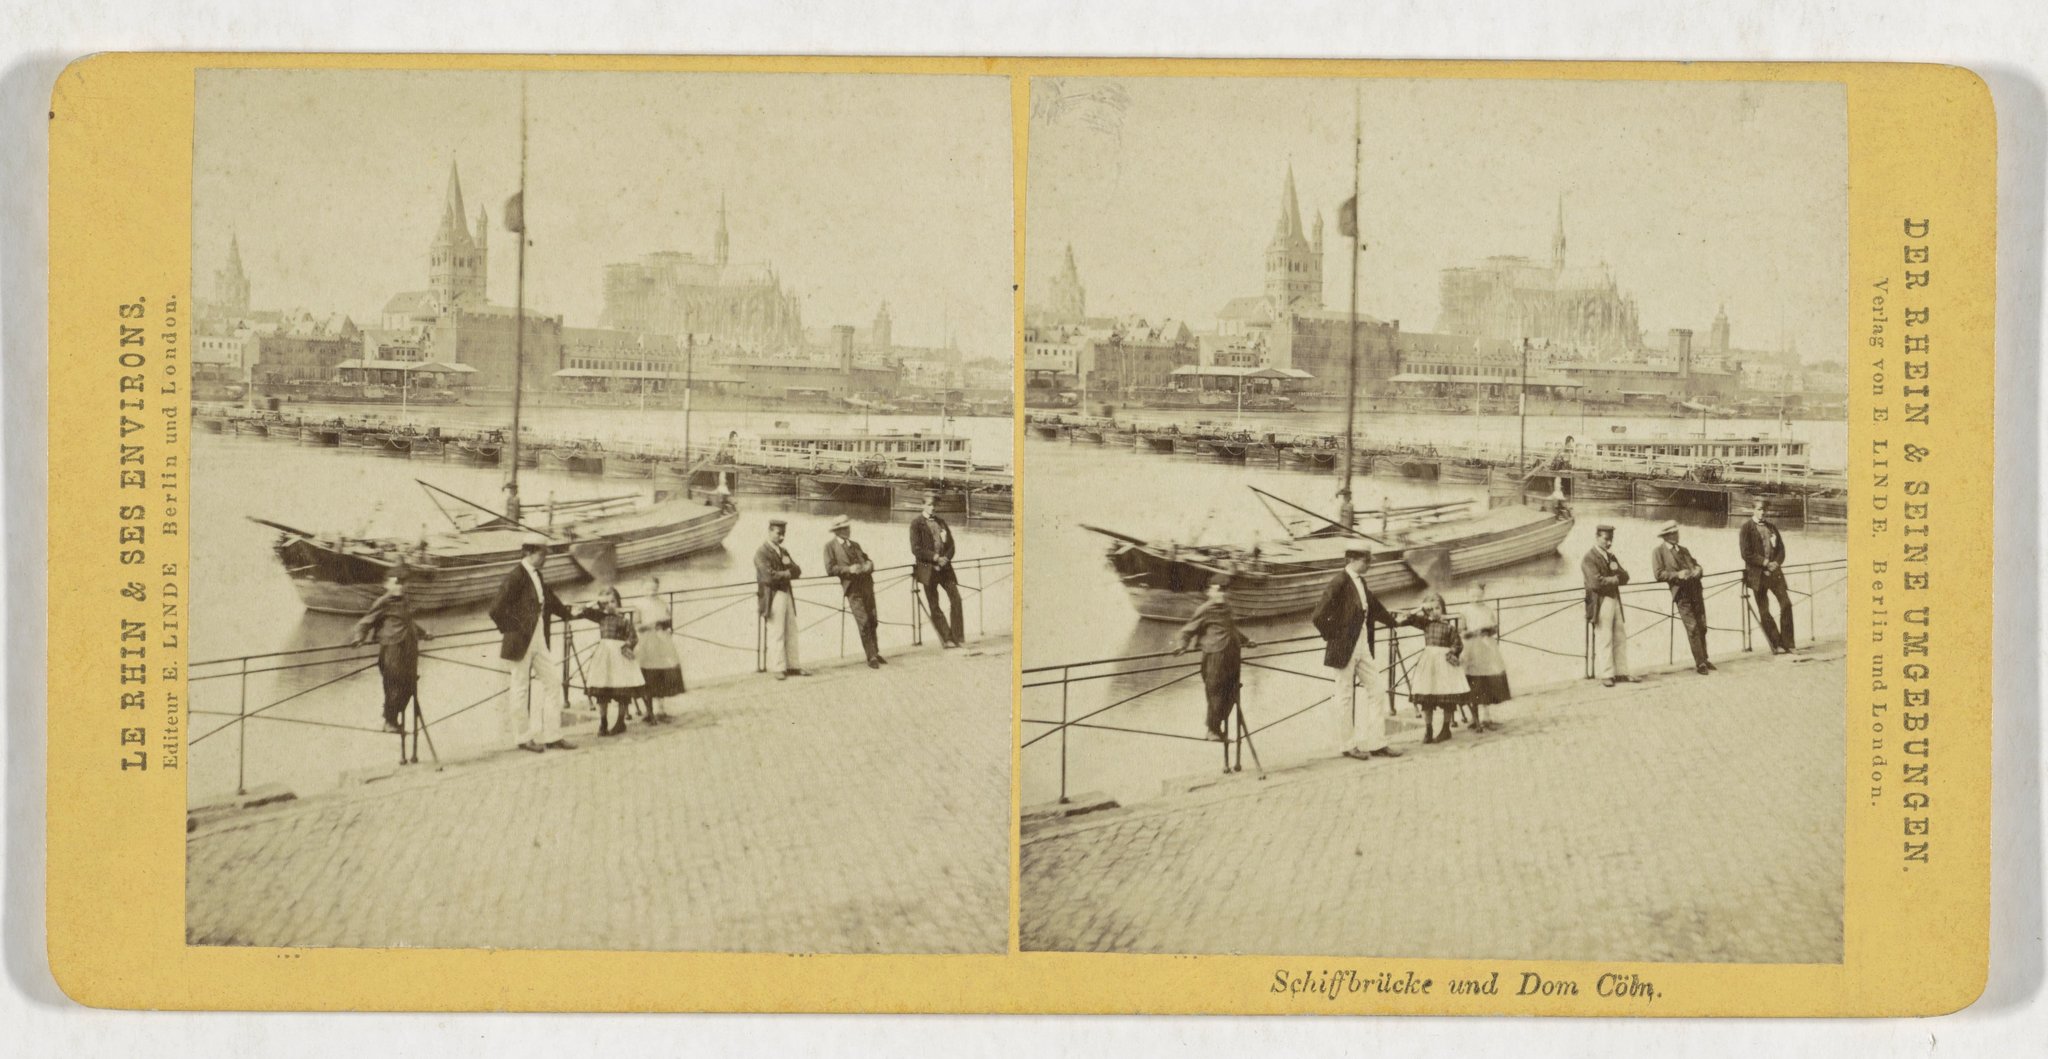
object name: stereograph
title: Schiffbrücke und Dom Cöln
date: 1868-1890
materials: cardboard, paper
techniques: albumen print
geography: cologne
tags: pontoon bridge, quay, cologne